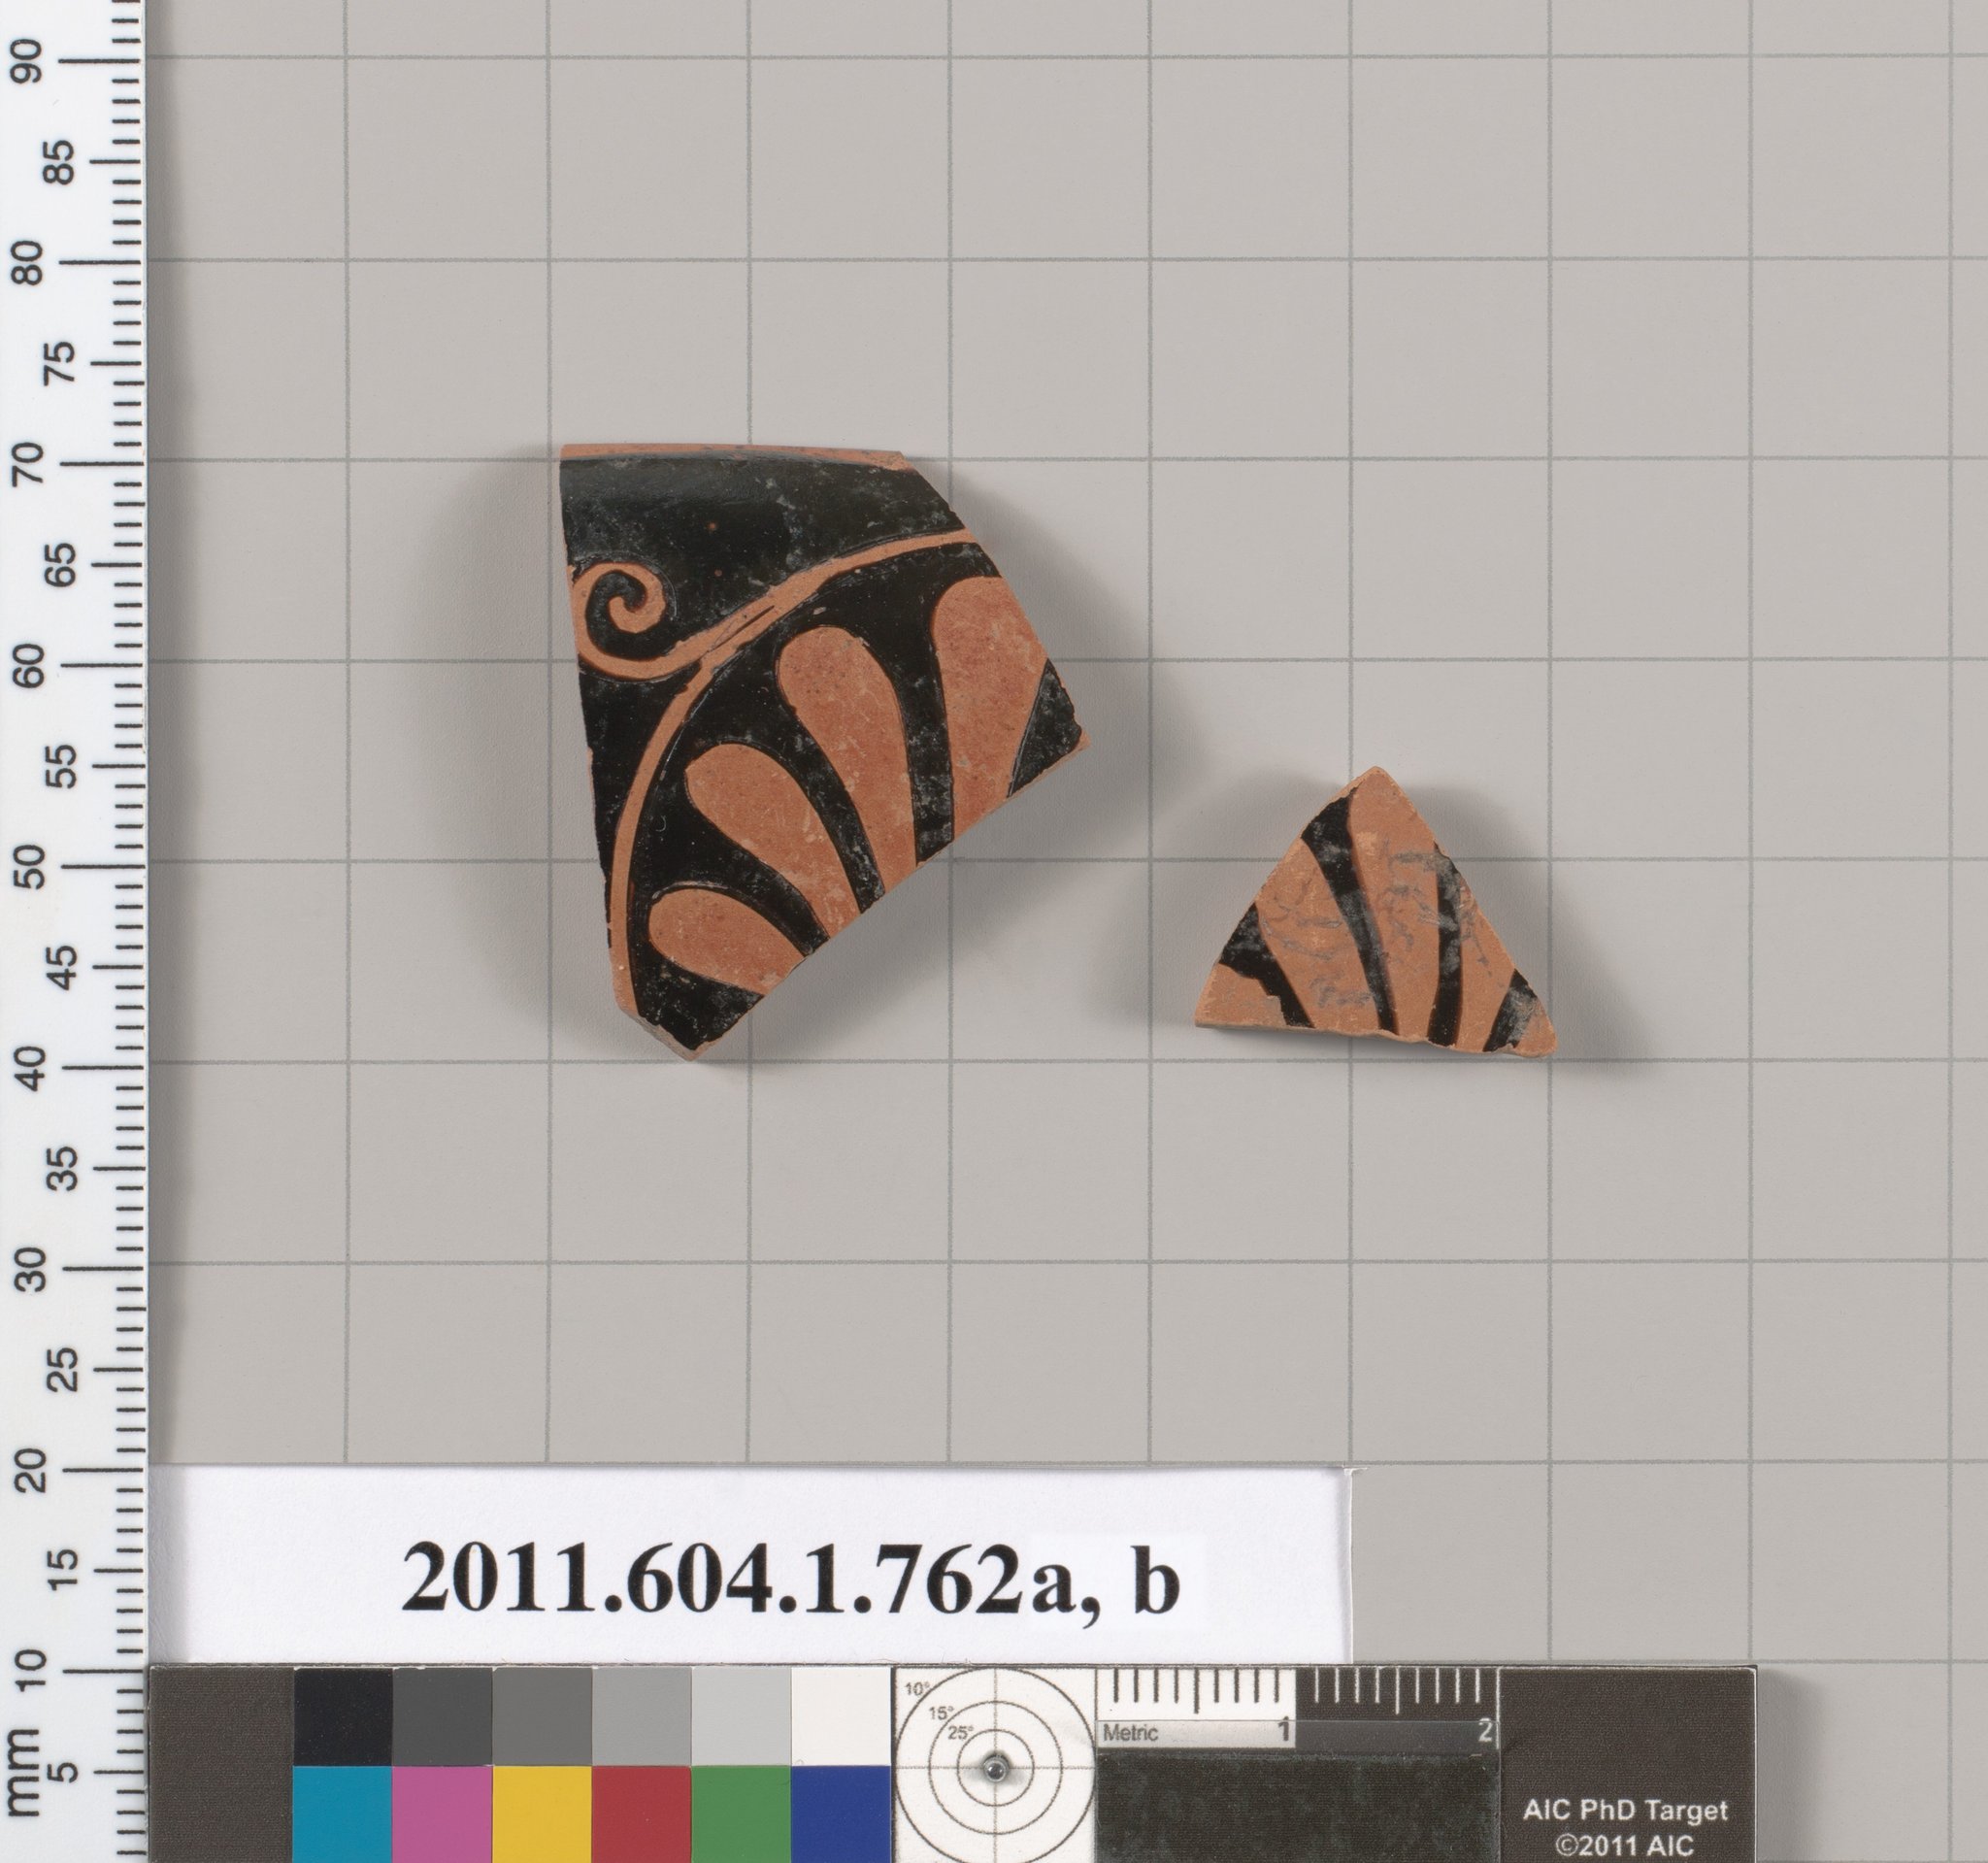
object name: kylix fragment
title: Terracotta fragments of kylikes (drinking cups)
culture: greek, attic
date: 490-480 BCE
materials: terracotta